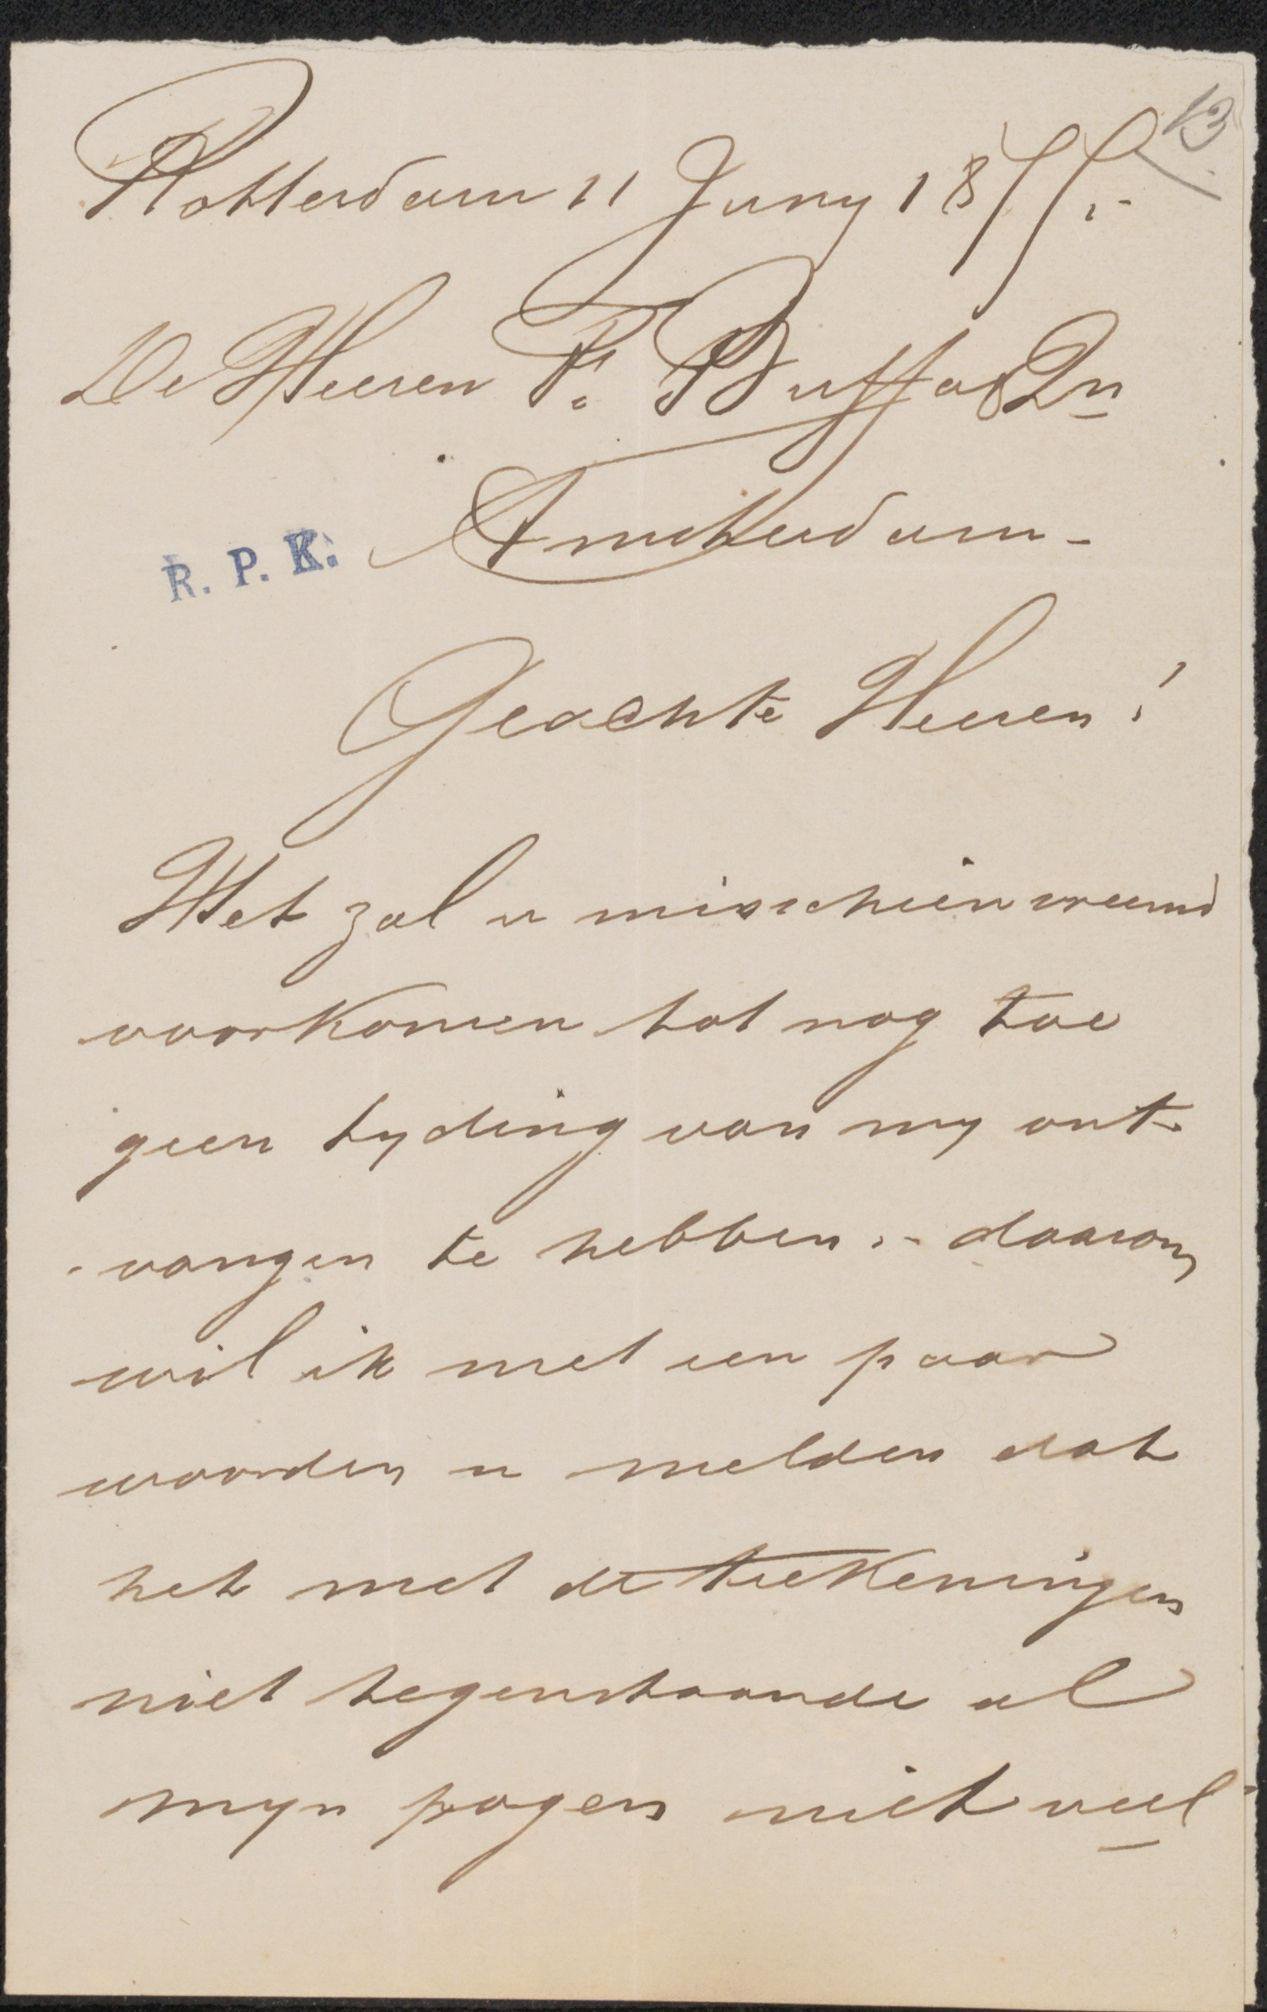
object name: letter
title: Brief aan Frans Buffa en Zonen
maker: charles rochussen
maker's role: draughtsman, painter, print maker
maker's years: 1814-1894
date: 1877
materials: ink, paper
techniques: pen, writing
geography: rotterdam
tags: dirk jurriaan sluyter, drawing, the graphic arts, amsterdam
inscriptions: collector's mark: Lugt 2233